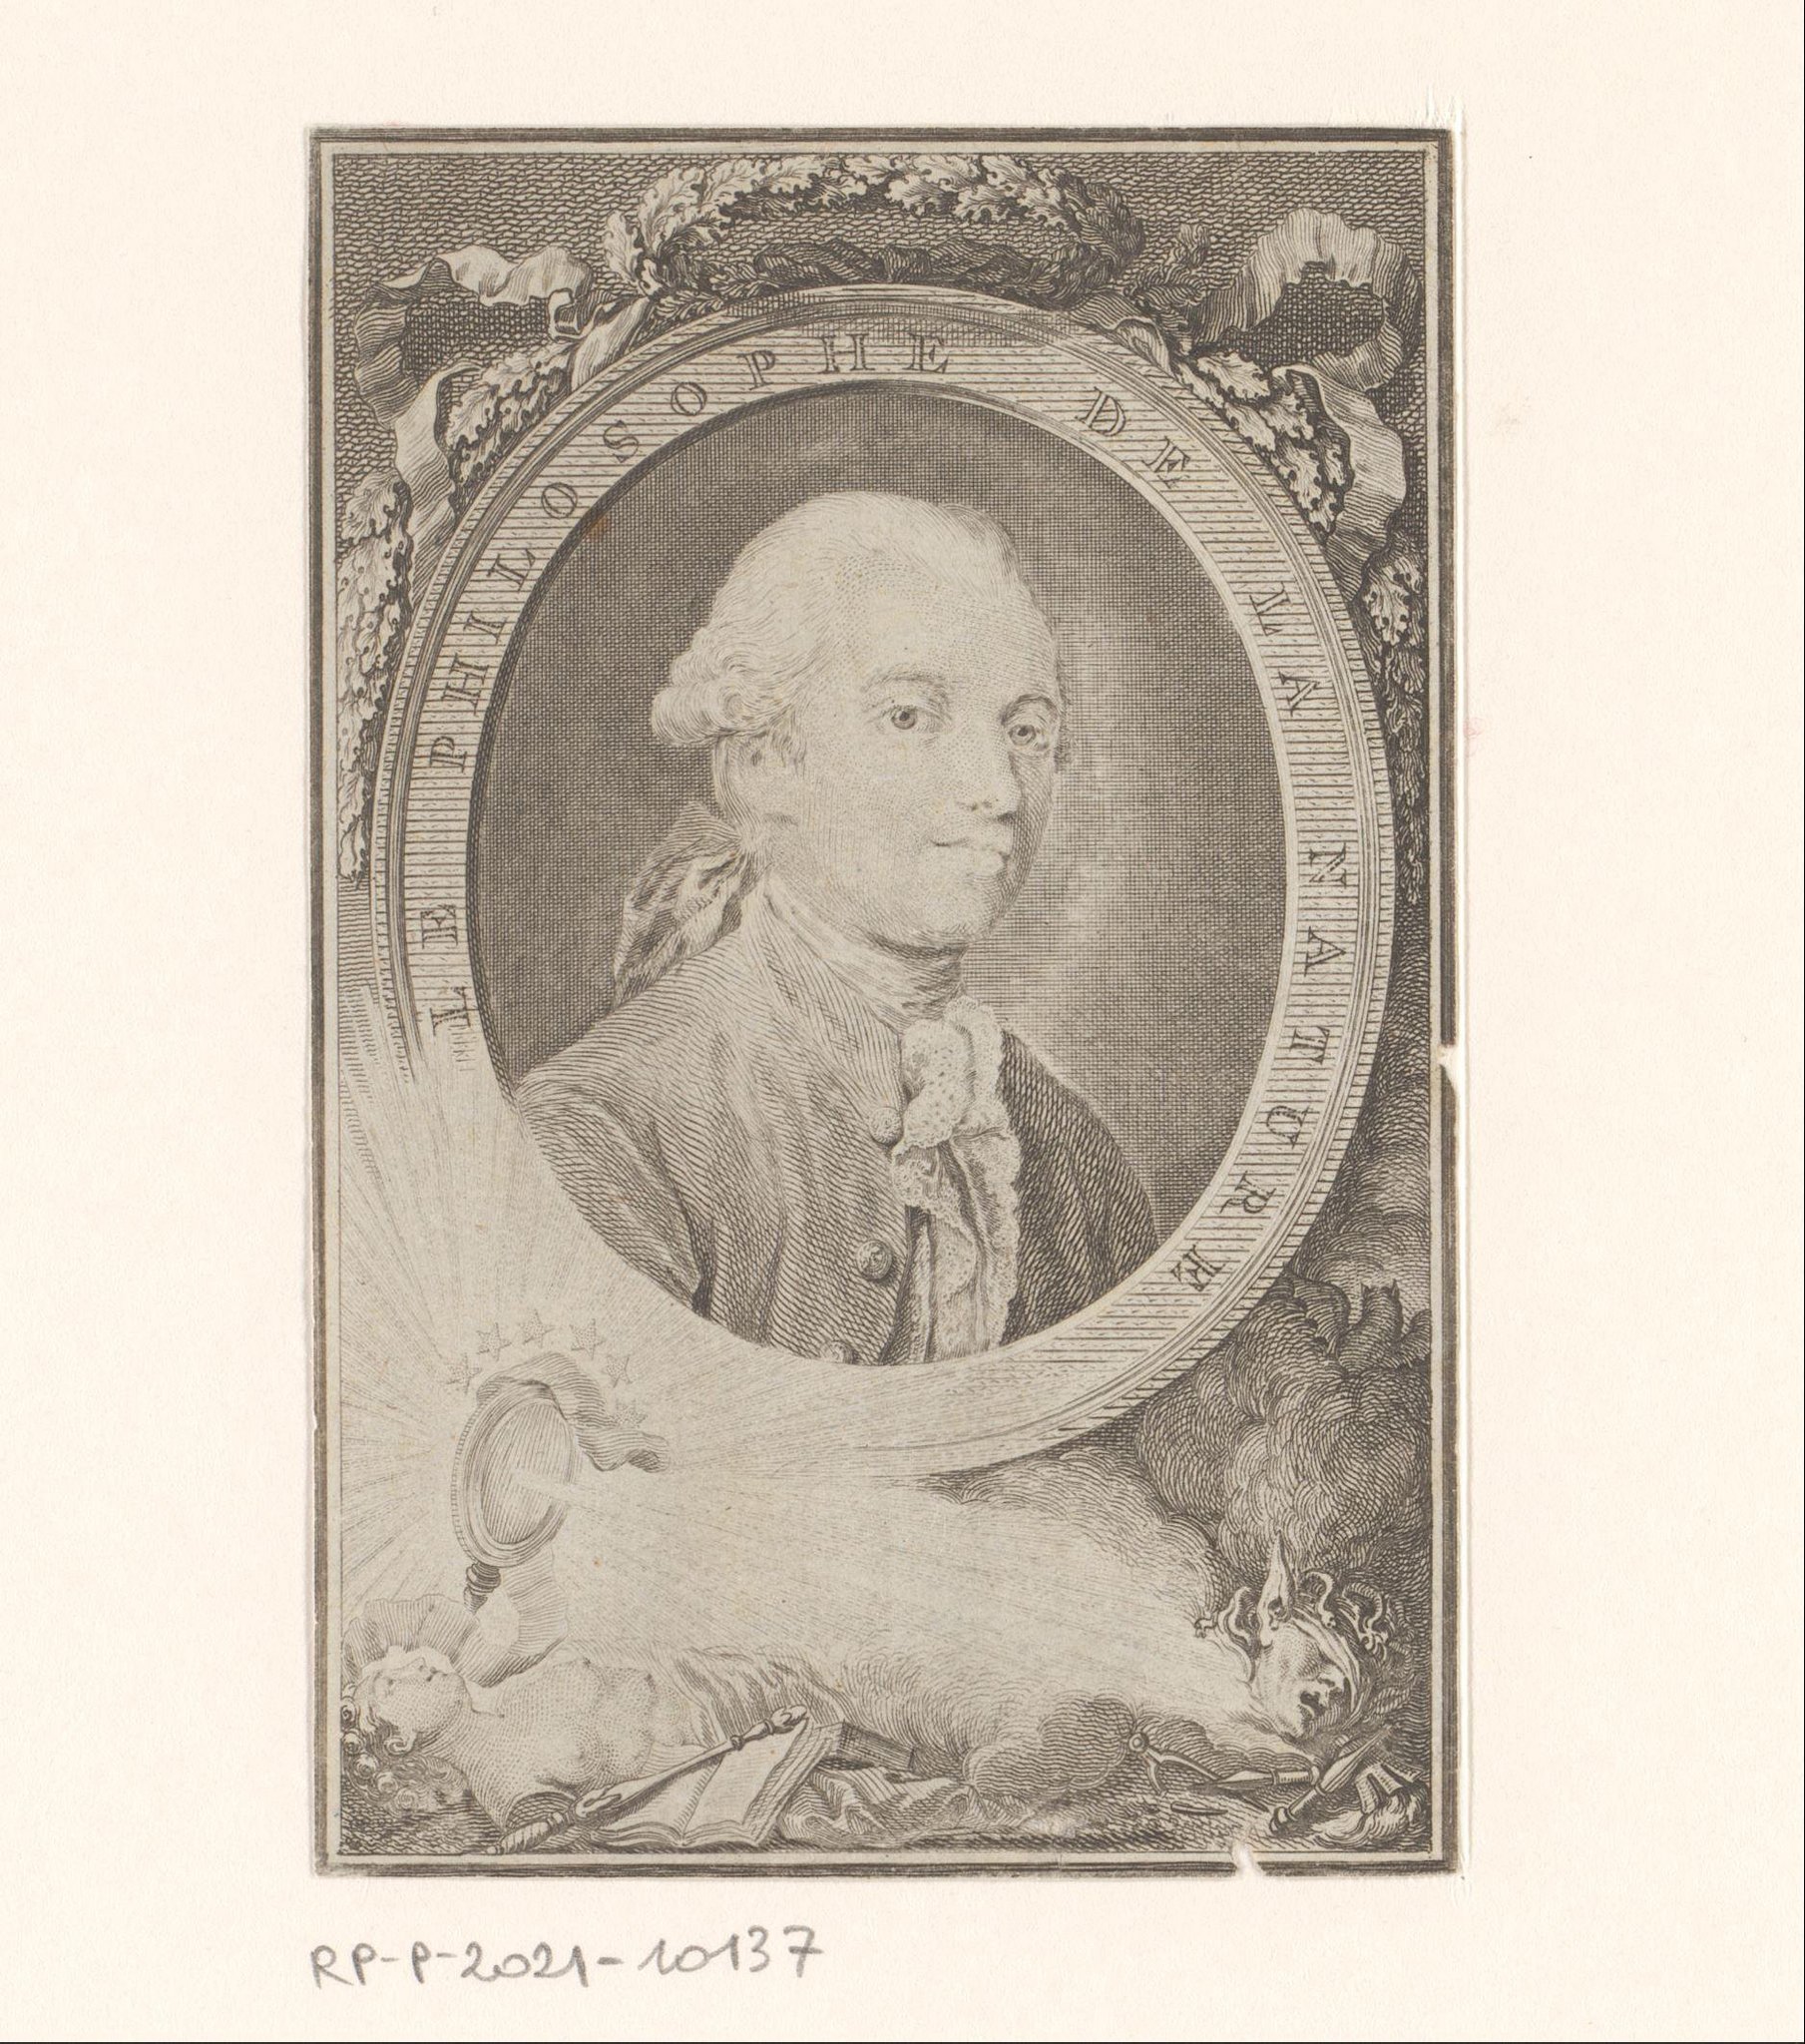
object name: book illustration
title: Portret van Jean-Baptiste-Claude Delisle de Sales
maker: Anonymous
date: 1796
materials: paper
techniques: engraving, etching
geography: france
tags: lyon, ornament ~ medallion, historical persons, scholar, philosopher (+ portrait of scholar, scientist)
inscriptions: collector's mark: Lugt 2228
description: Prent waarschijnlijk uit: Delisle de Sales, Jean-Baptiste-Claude. De la Philosophie du Bonheur (...). Parijs: Jean-Baptiste-Claude Delisle de Sales, 1796, dl. 1.